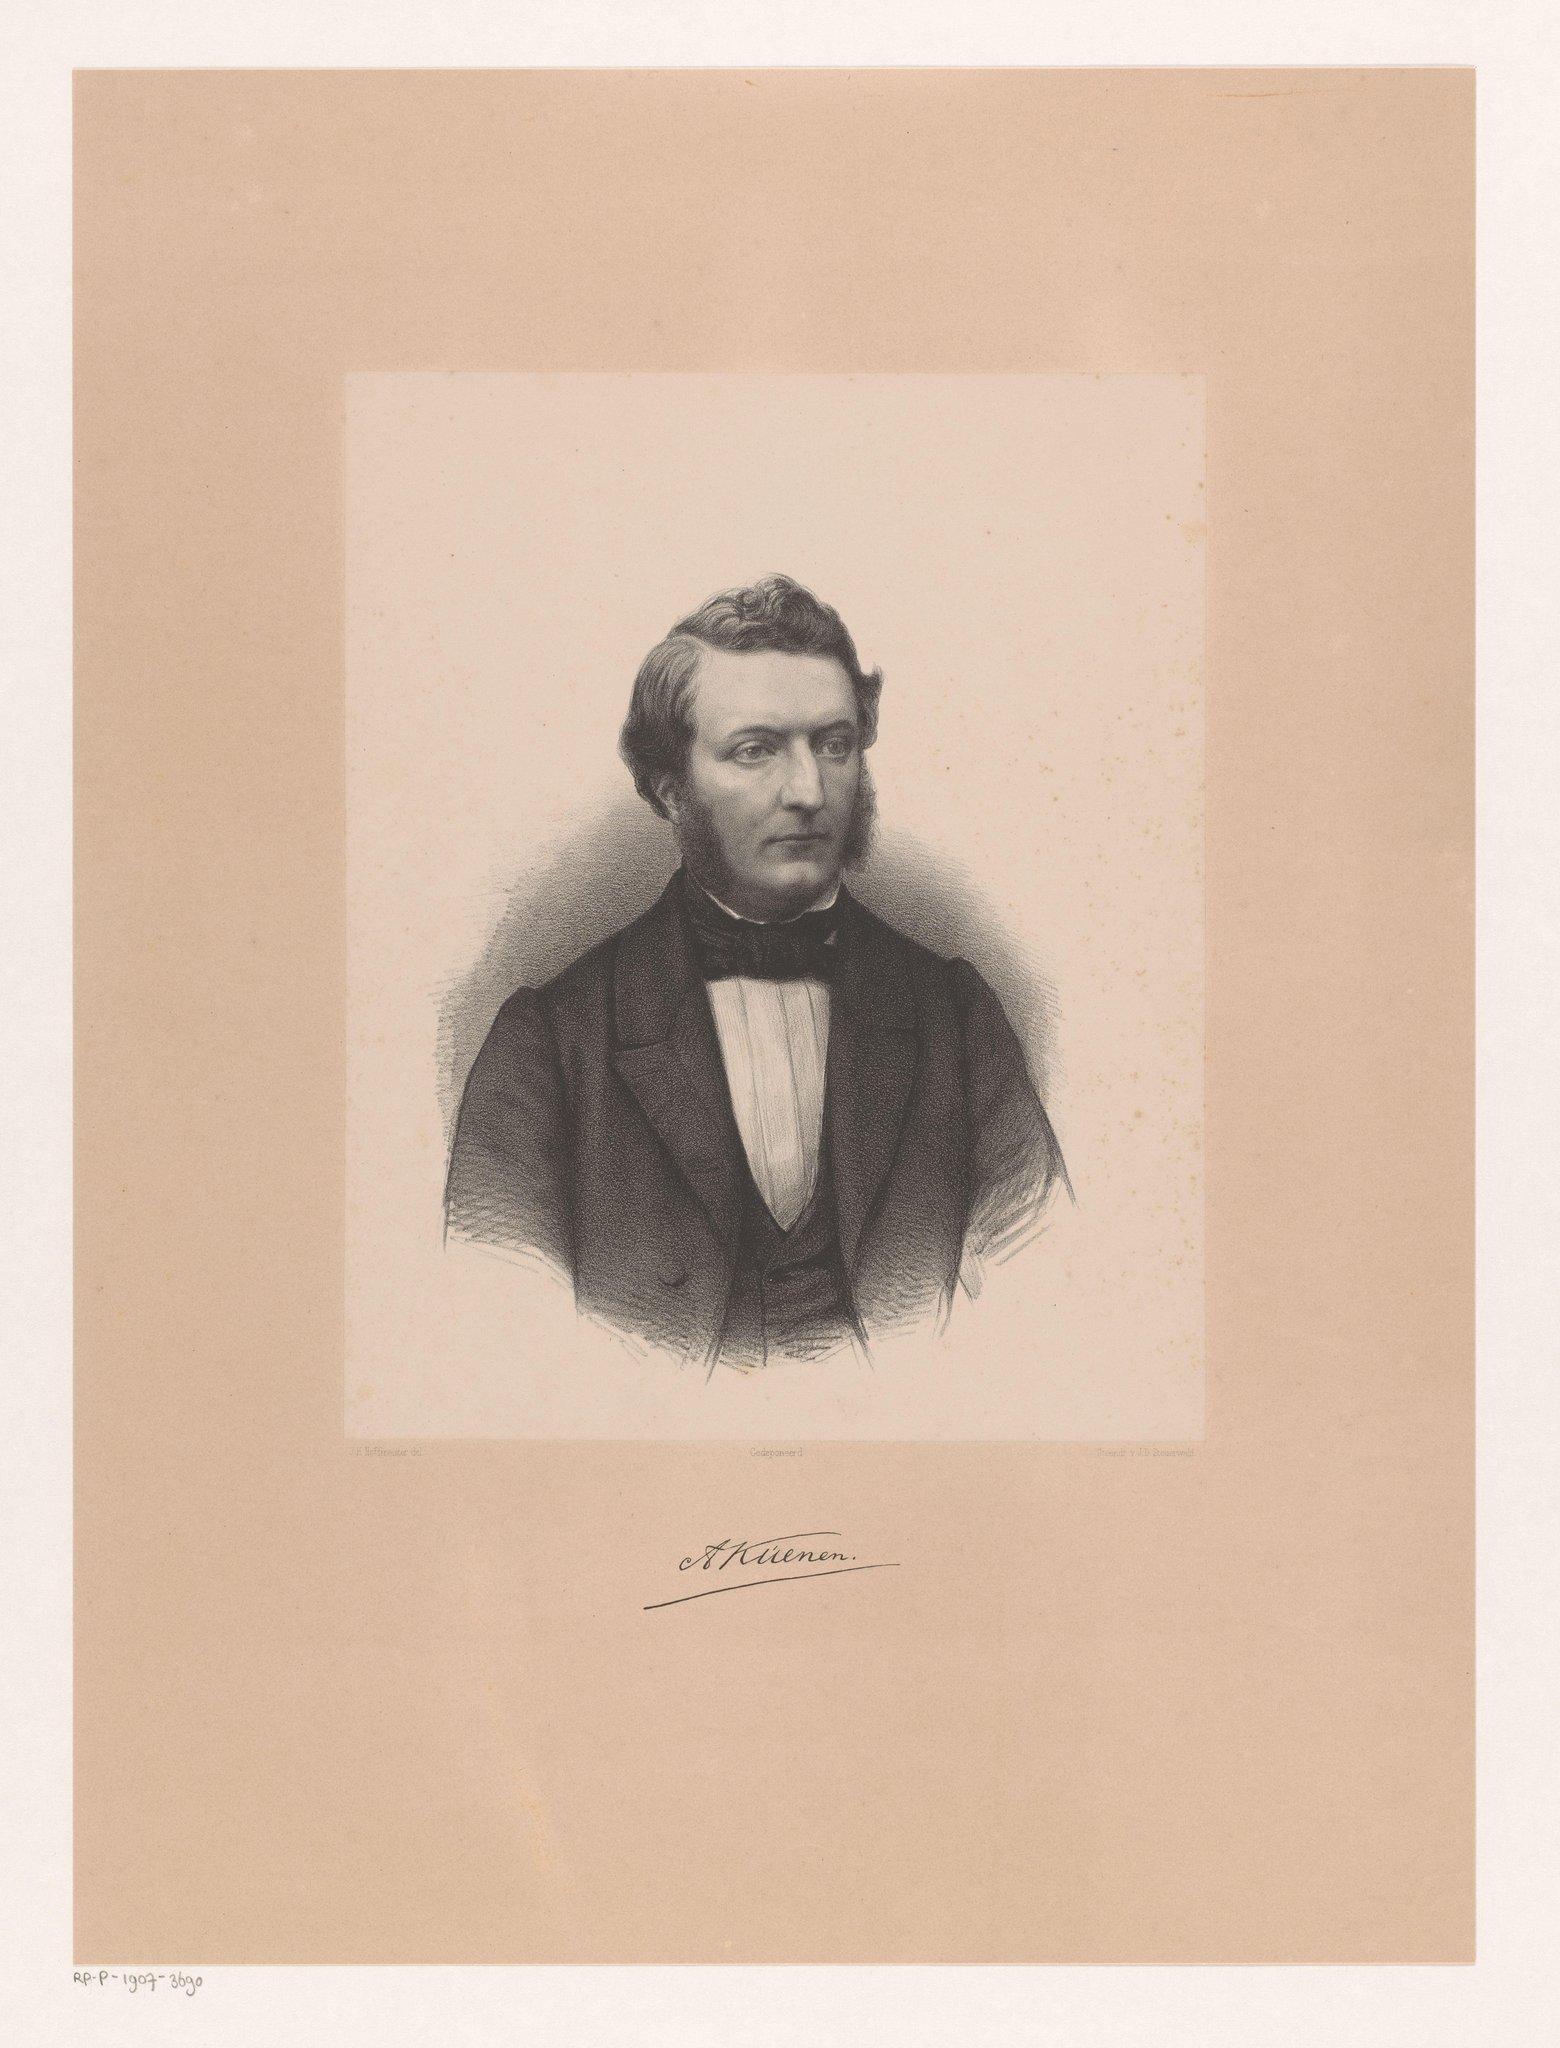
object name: print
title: Portret van Abraham Kuenen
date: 1843-1863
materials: paper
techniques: lithograph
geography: netherlands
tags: leiden, historical persons (+ (full) bust portrait)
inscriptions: collector's mark: Lugt 2228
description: Onder het portret de signatuur van de geportretteerde.